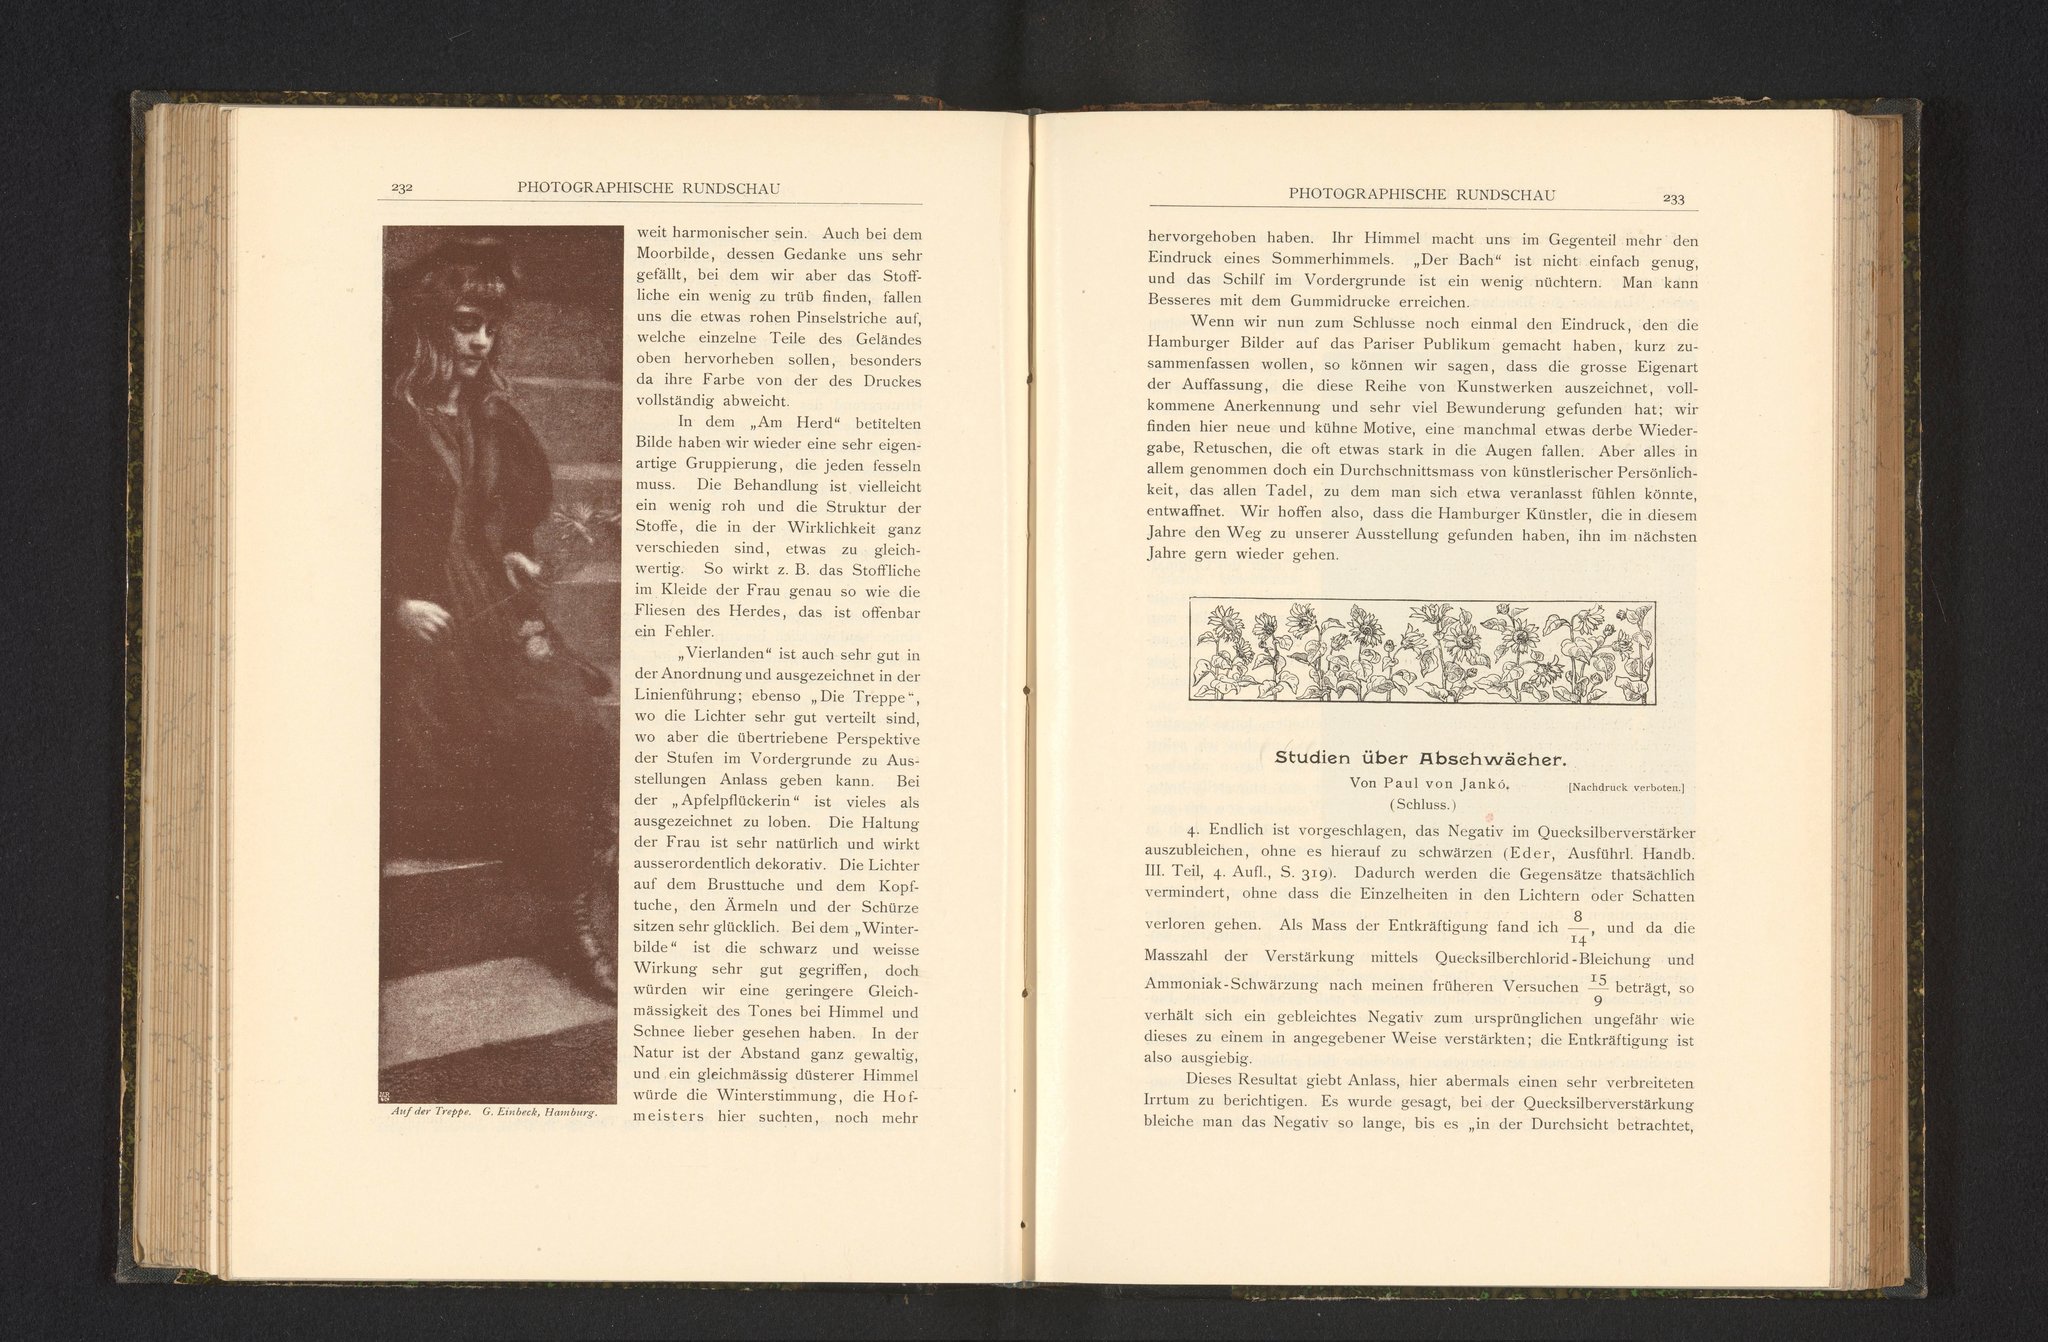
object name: page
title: Portret van een onbekende jonge vrouw op de trap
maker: george einbeck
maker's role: painter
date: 1893-1898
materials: paper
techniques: autotype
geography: berlin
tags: flight of steps, anonymous historical person portrayed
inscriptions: monogram: ‘MR/ &Co’